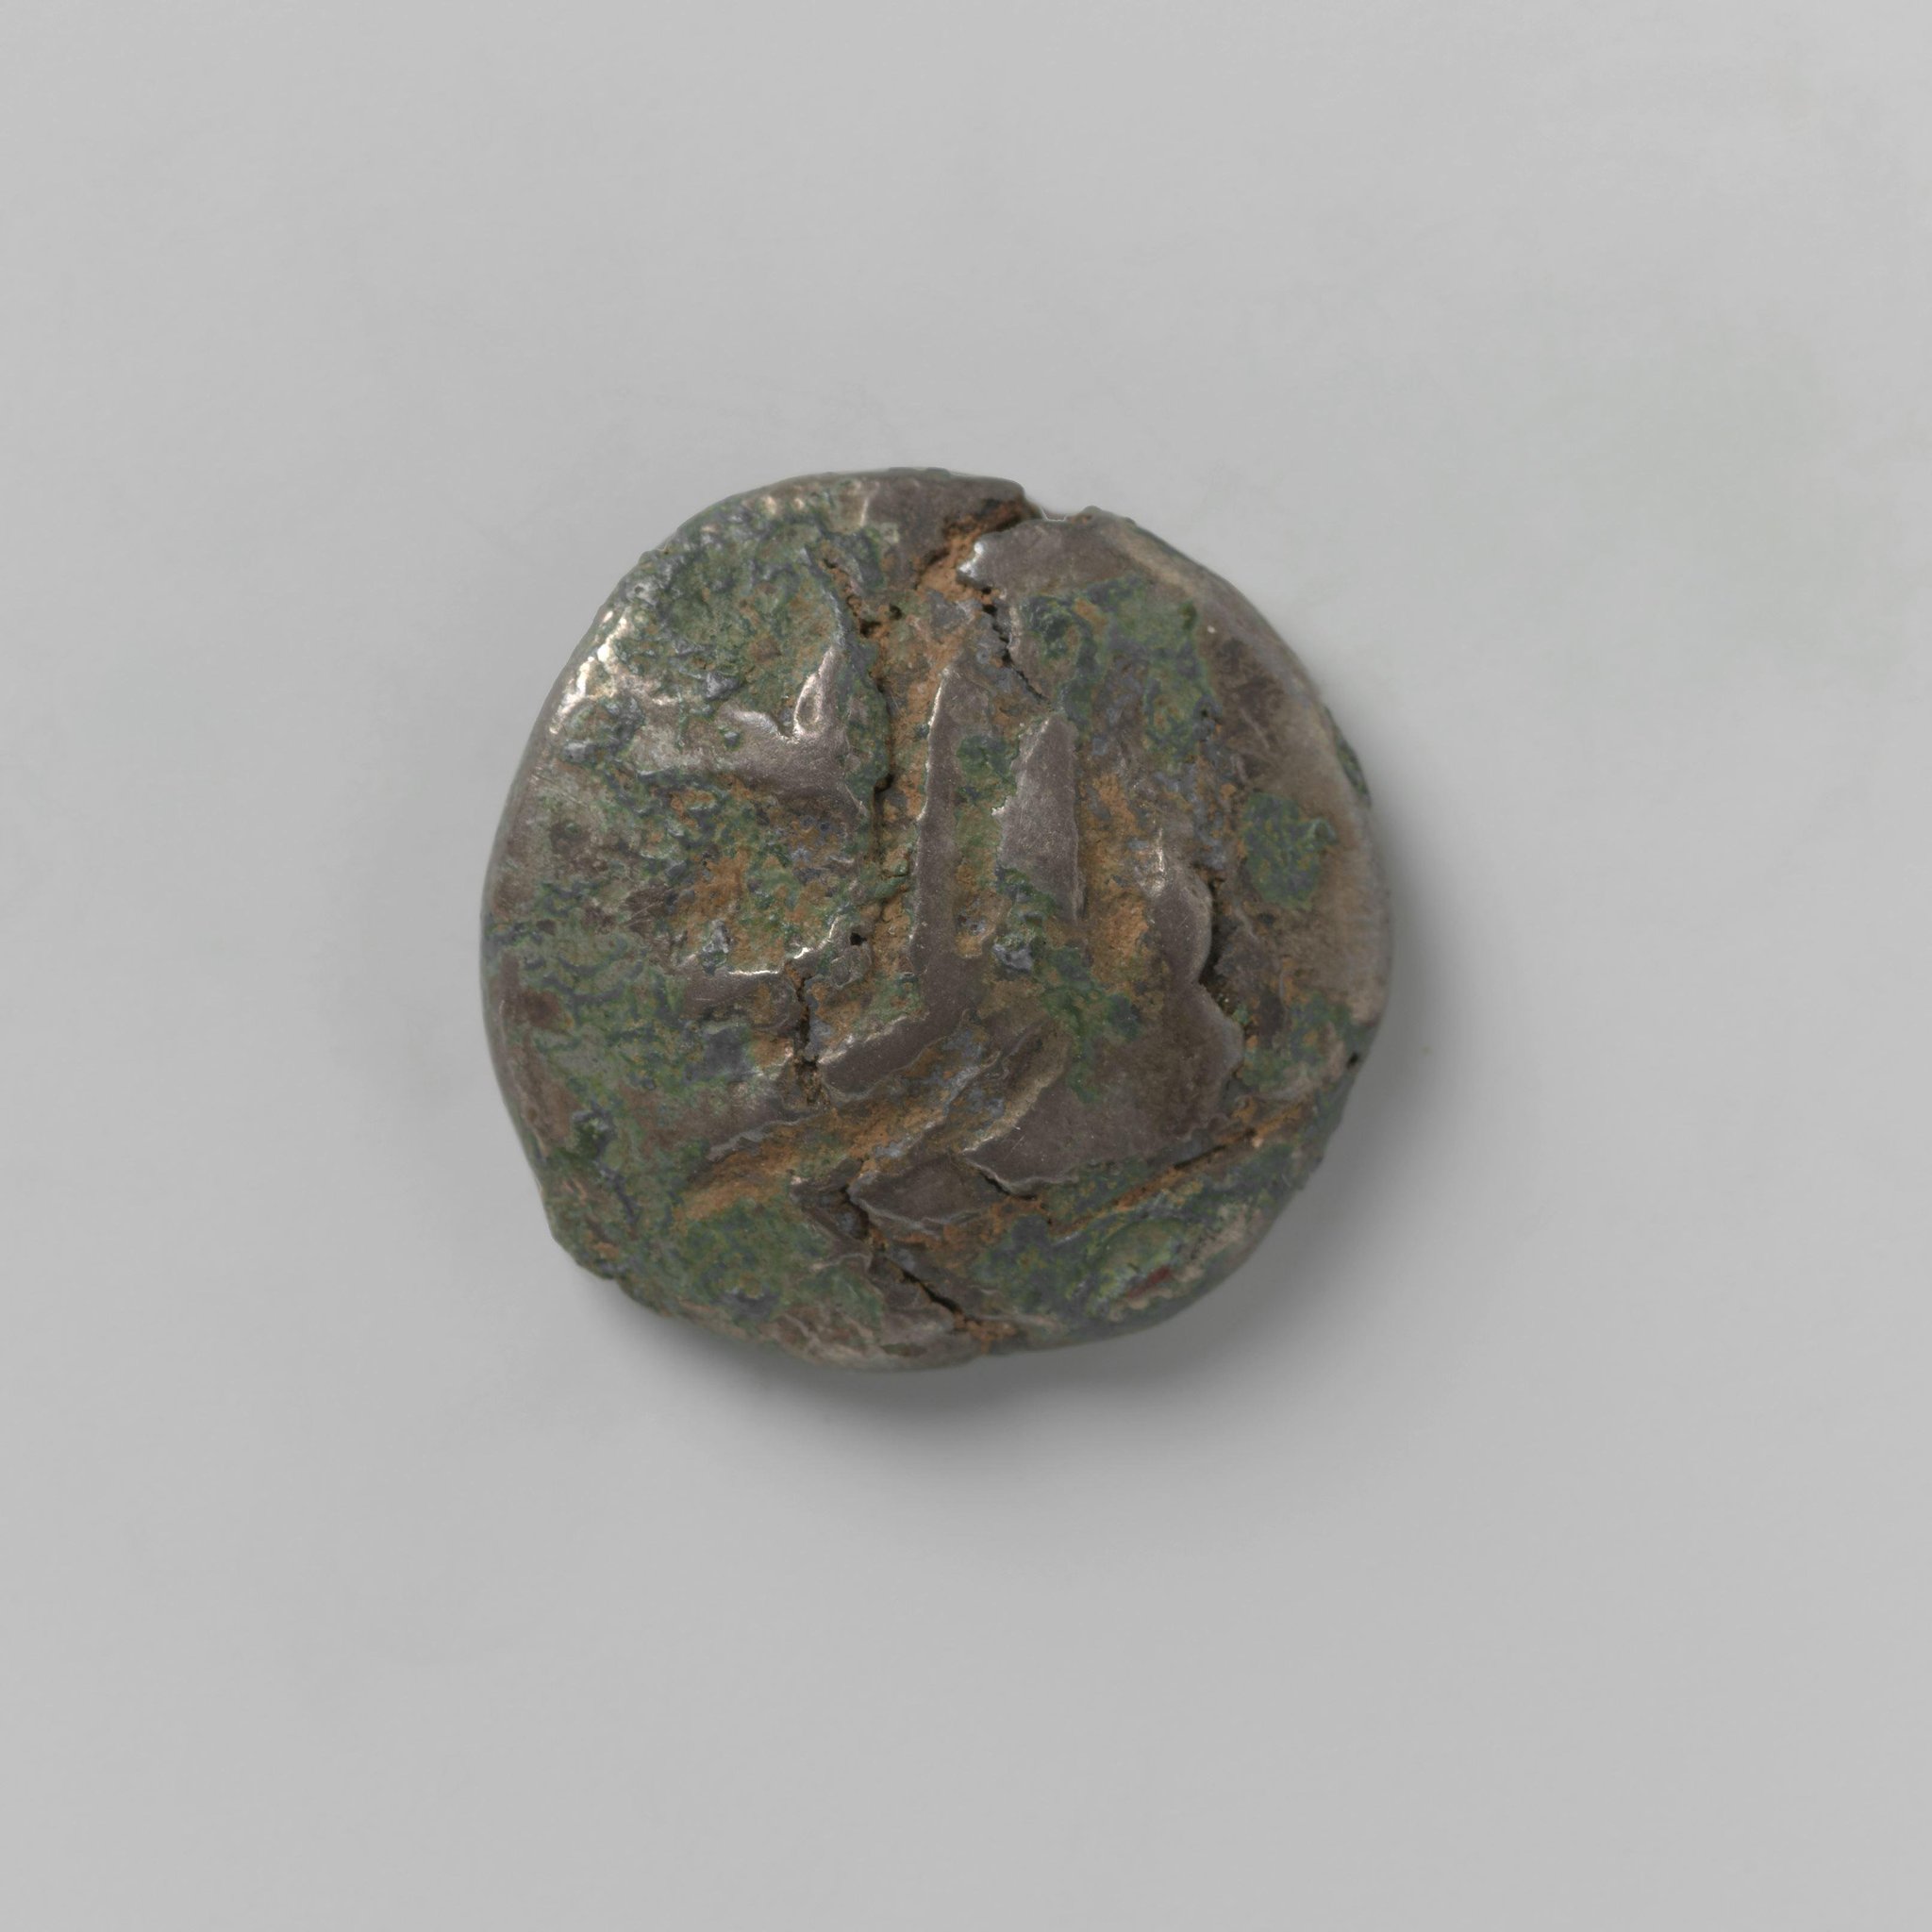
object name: coin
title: Java, koninkrijk Majopahit, djampel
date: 1290-1520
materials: silver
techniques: striking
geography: java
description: Zilveren schotelvormige munt. Voorzijde: letterteken in devanagari-schrift [maa?]. Keerzijde, figuratie [bloem?].